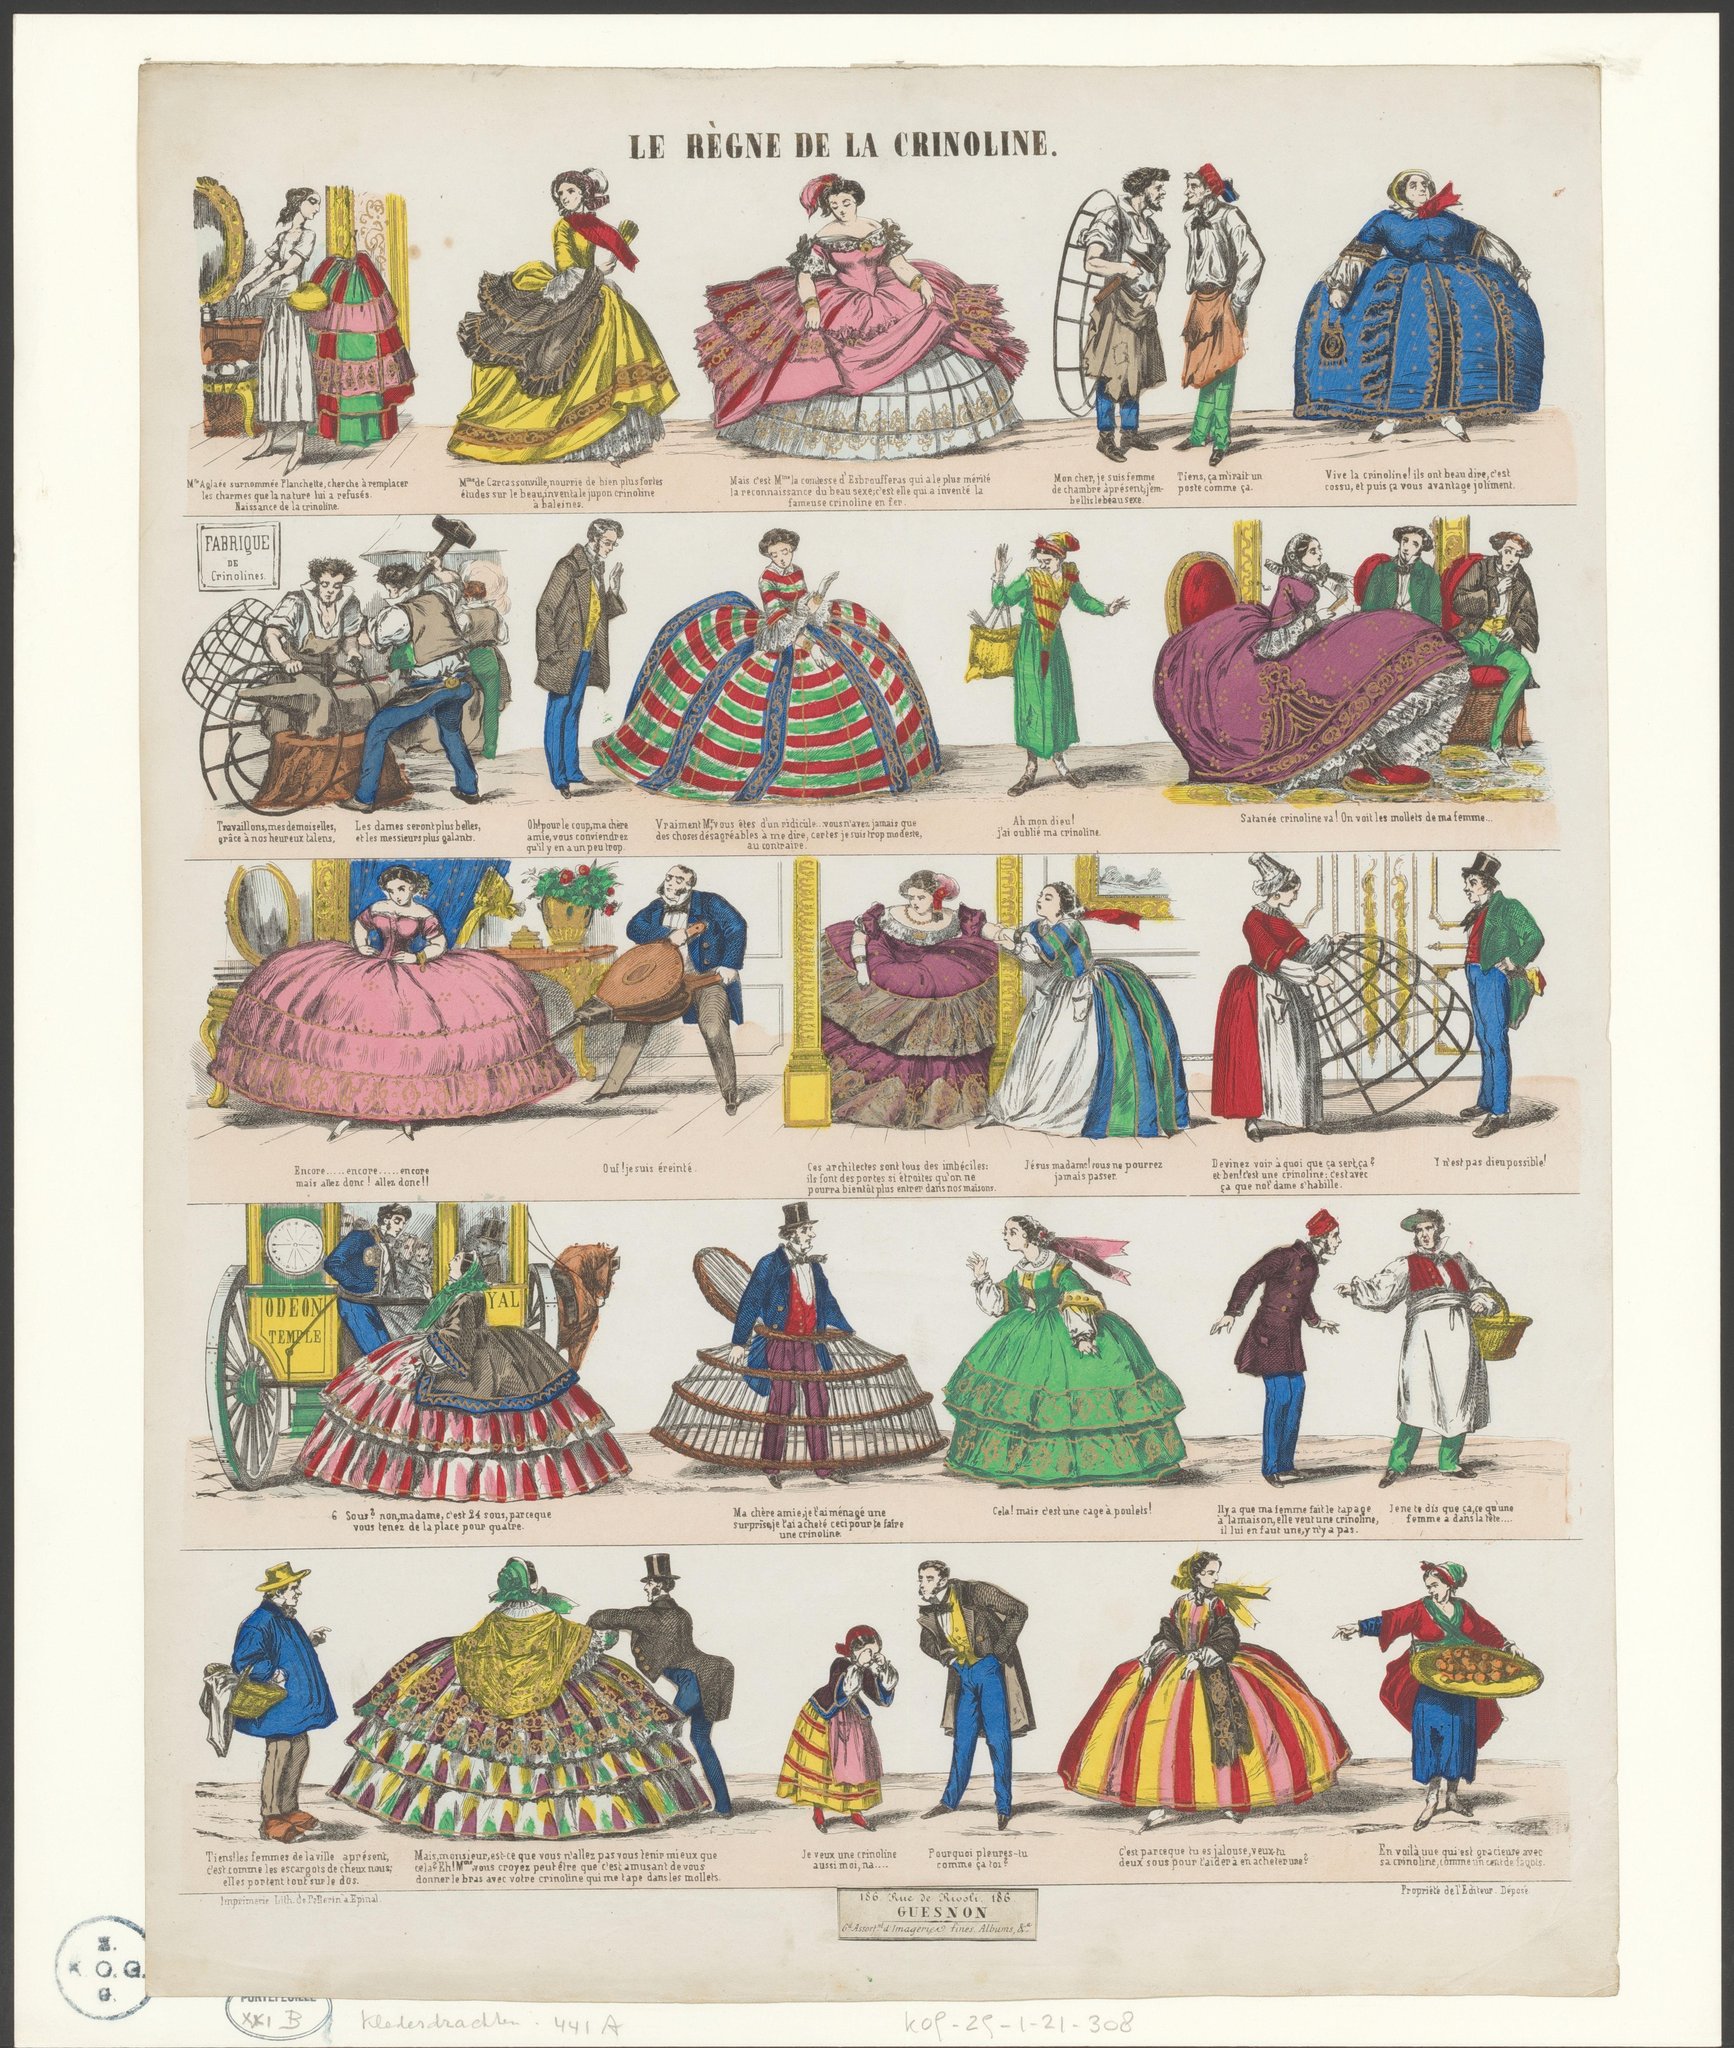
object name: print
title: Bewind van de hoepelrokken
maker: Anonymous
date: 1850-1870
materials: paint, paper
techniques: hand coloring, lithograph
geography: epinal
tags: skirt (crinoline skirt) (+ women's clothes)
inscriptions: collector's mark: Lugt 1641, : ‘Propriété de l'Editeur. Déposé’, stamp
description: Volksprent met grappen over de hoepelrok of crinoline. De rokken van vrouwen hadden een wijde omtrek wat voor veel onhandigheden zorgden. Zo past een vrouw niet door de deur heen en een andere vrouw mag niet mee in een koets. Onderwerpsrubrieken binnen de Atlas Zeden en Gewoonten: Zeden en Gewoonten in Engeren Zin, De Kleeding, Kleederdrachten (tijdvakken), De crinolinetijd.